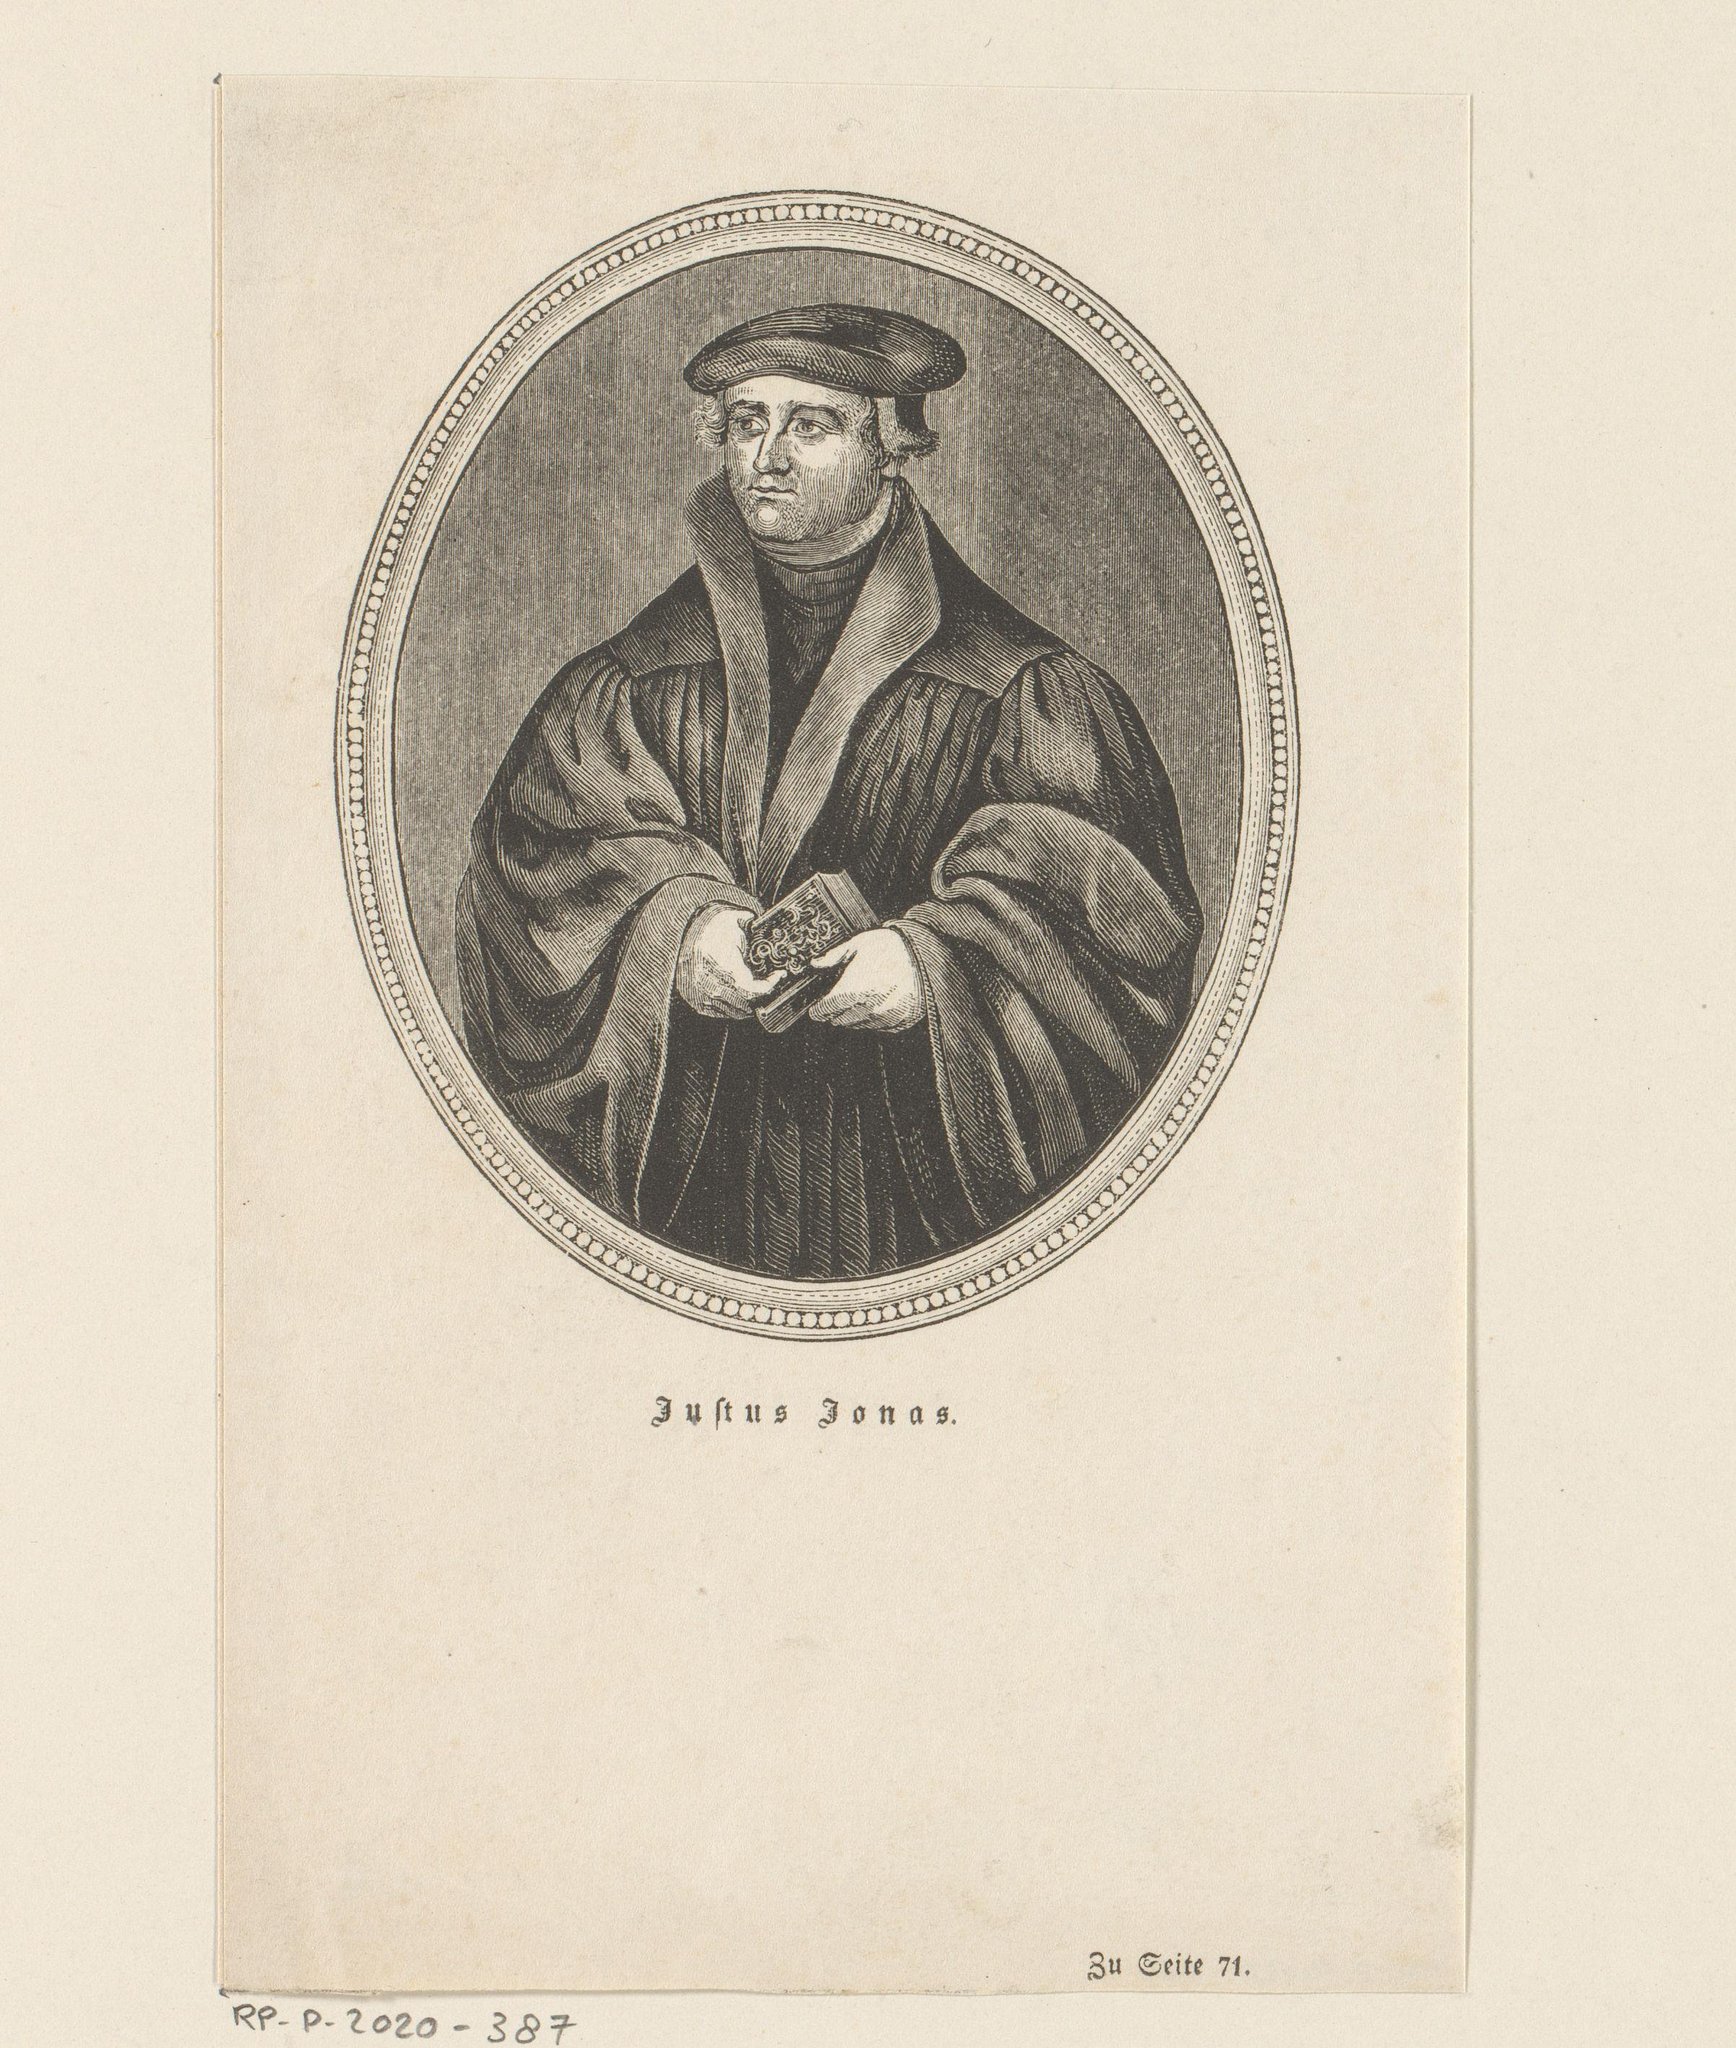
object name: print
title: Portret van Justus Jonas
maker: Anonymous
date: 1800-1849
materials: paper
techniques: letterpress printing, engraving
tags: theologian, historical persons, book